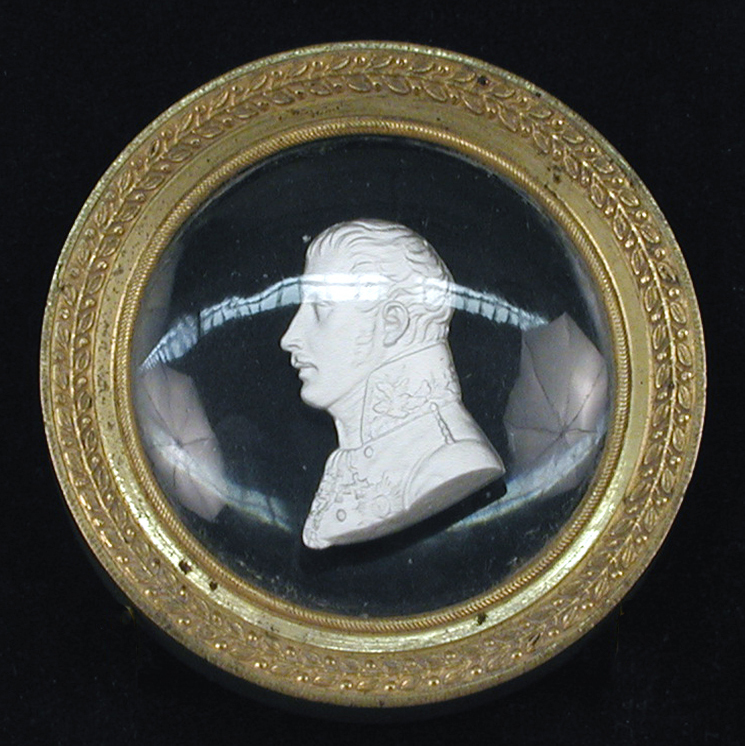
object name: medallion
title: Friedrich Wilhelm III of Prussia (1770–1840, r. 1797–1840)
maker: désprez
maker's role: maker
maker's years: 1773-1815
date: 1815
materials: biscuit, gilt copper, glass, porcelain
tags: men,profiles